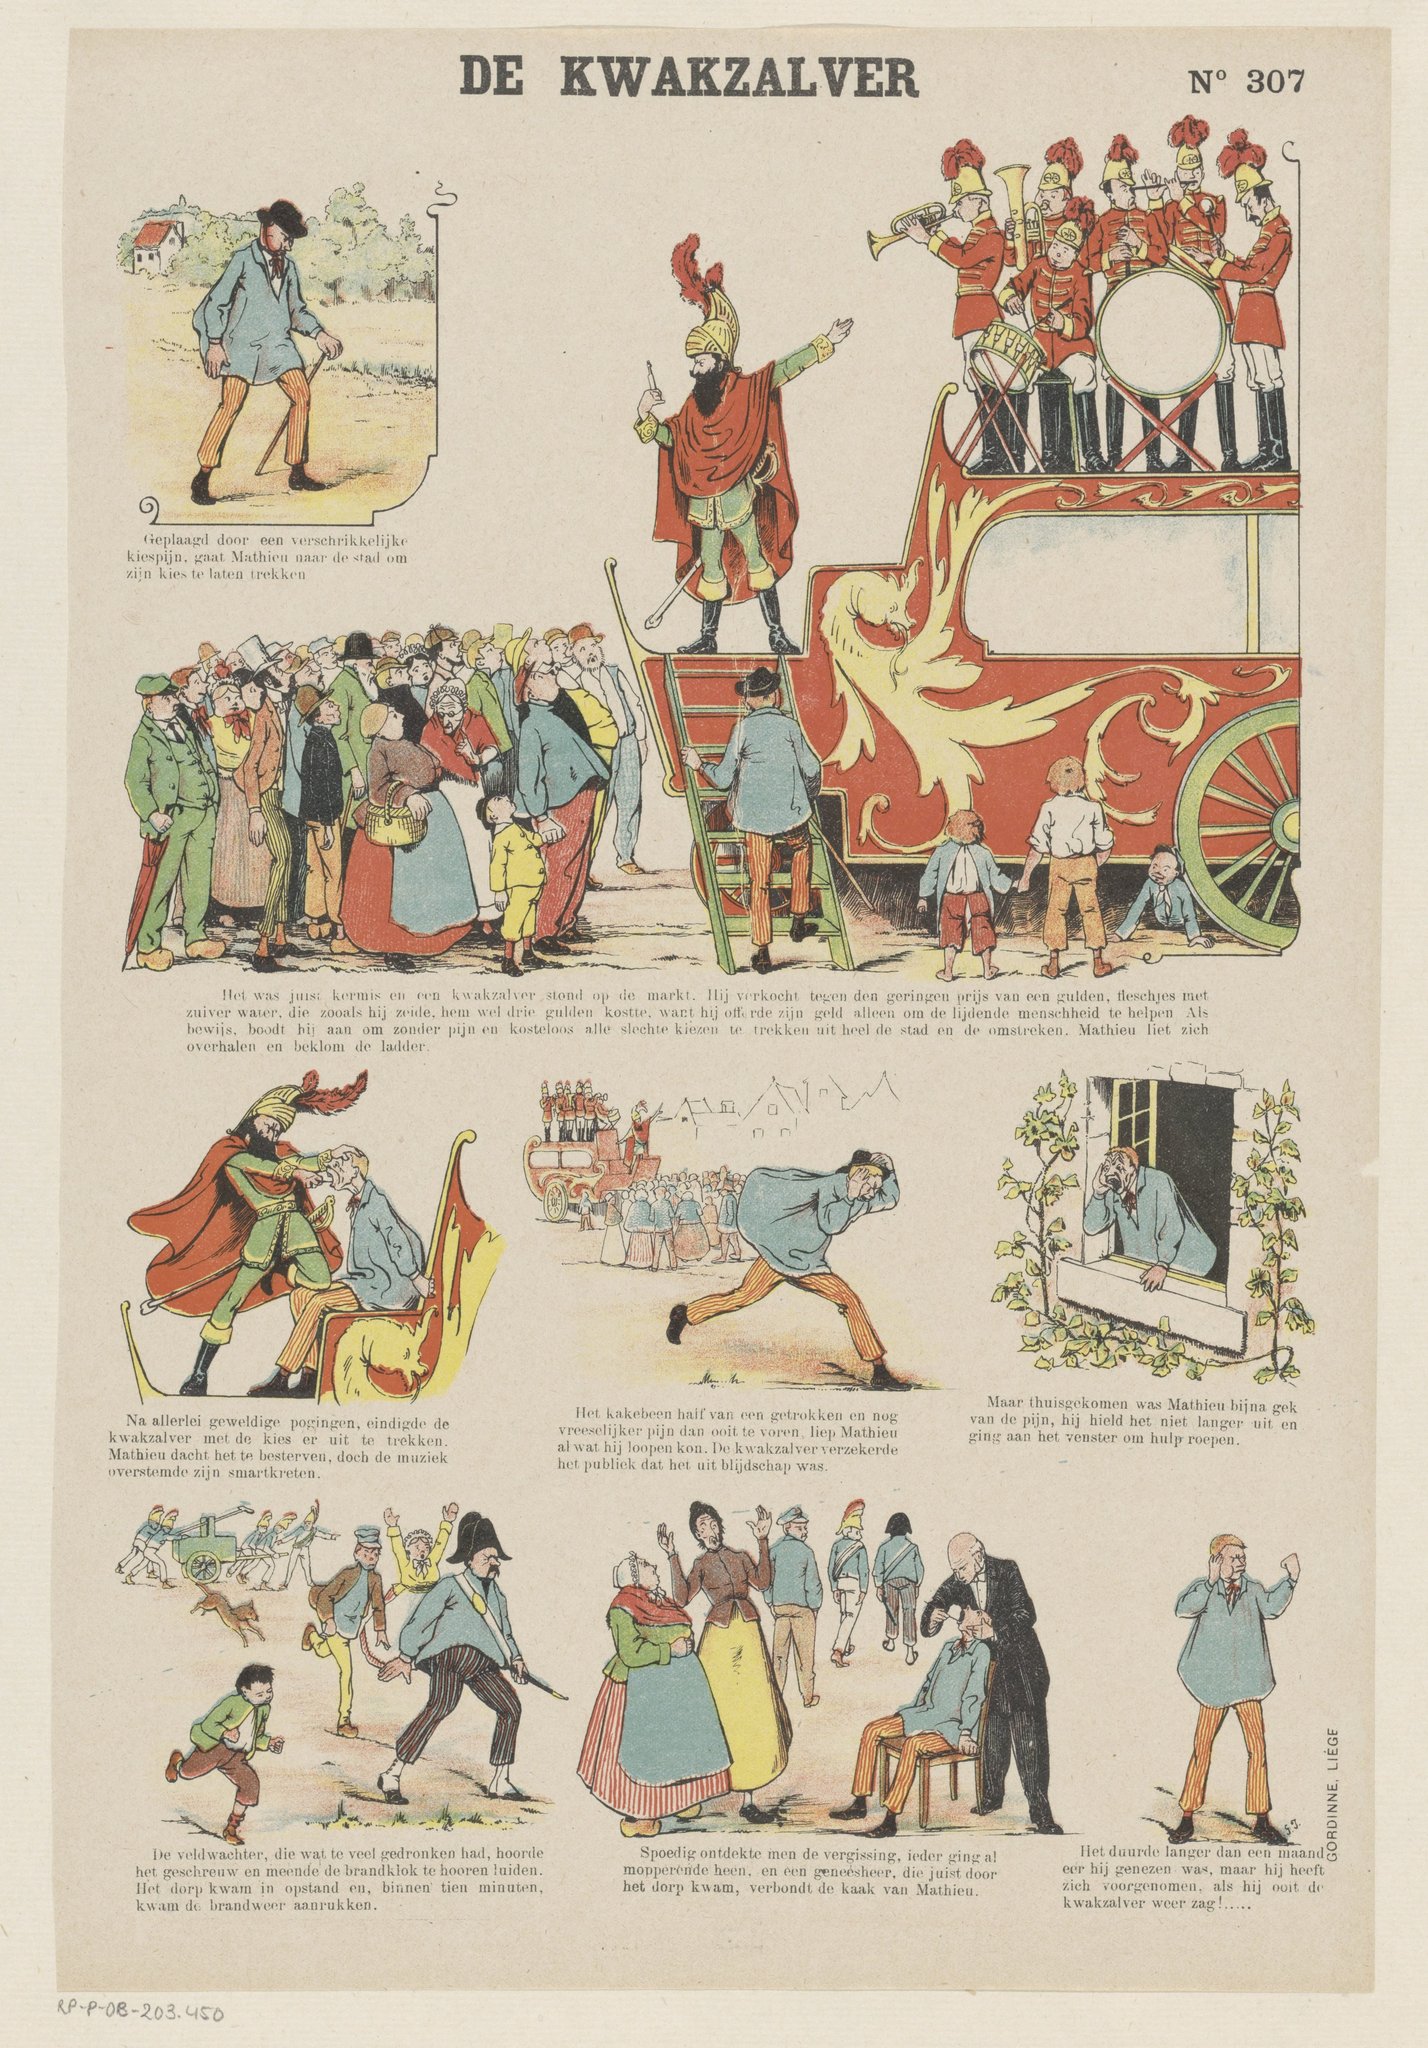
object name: popular print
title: De kwakzalver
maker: Anonymous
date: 1894-1959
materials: paper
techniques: lithograph, letterpress printing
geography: liège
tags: quack, charlatan, mountebank, 'saltimbanco', quack extracting teeth or molars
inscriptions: collector's mark: Lugt 2760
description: Blad met 8 voorstellingen over Mathieu die zijn kies laat trekken door een kwakzalver. Onder elke afbeelding een onderschrift. Genummerd rechtsboven: No 307.